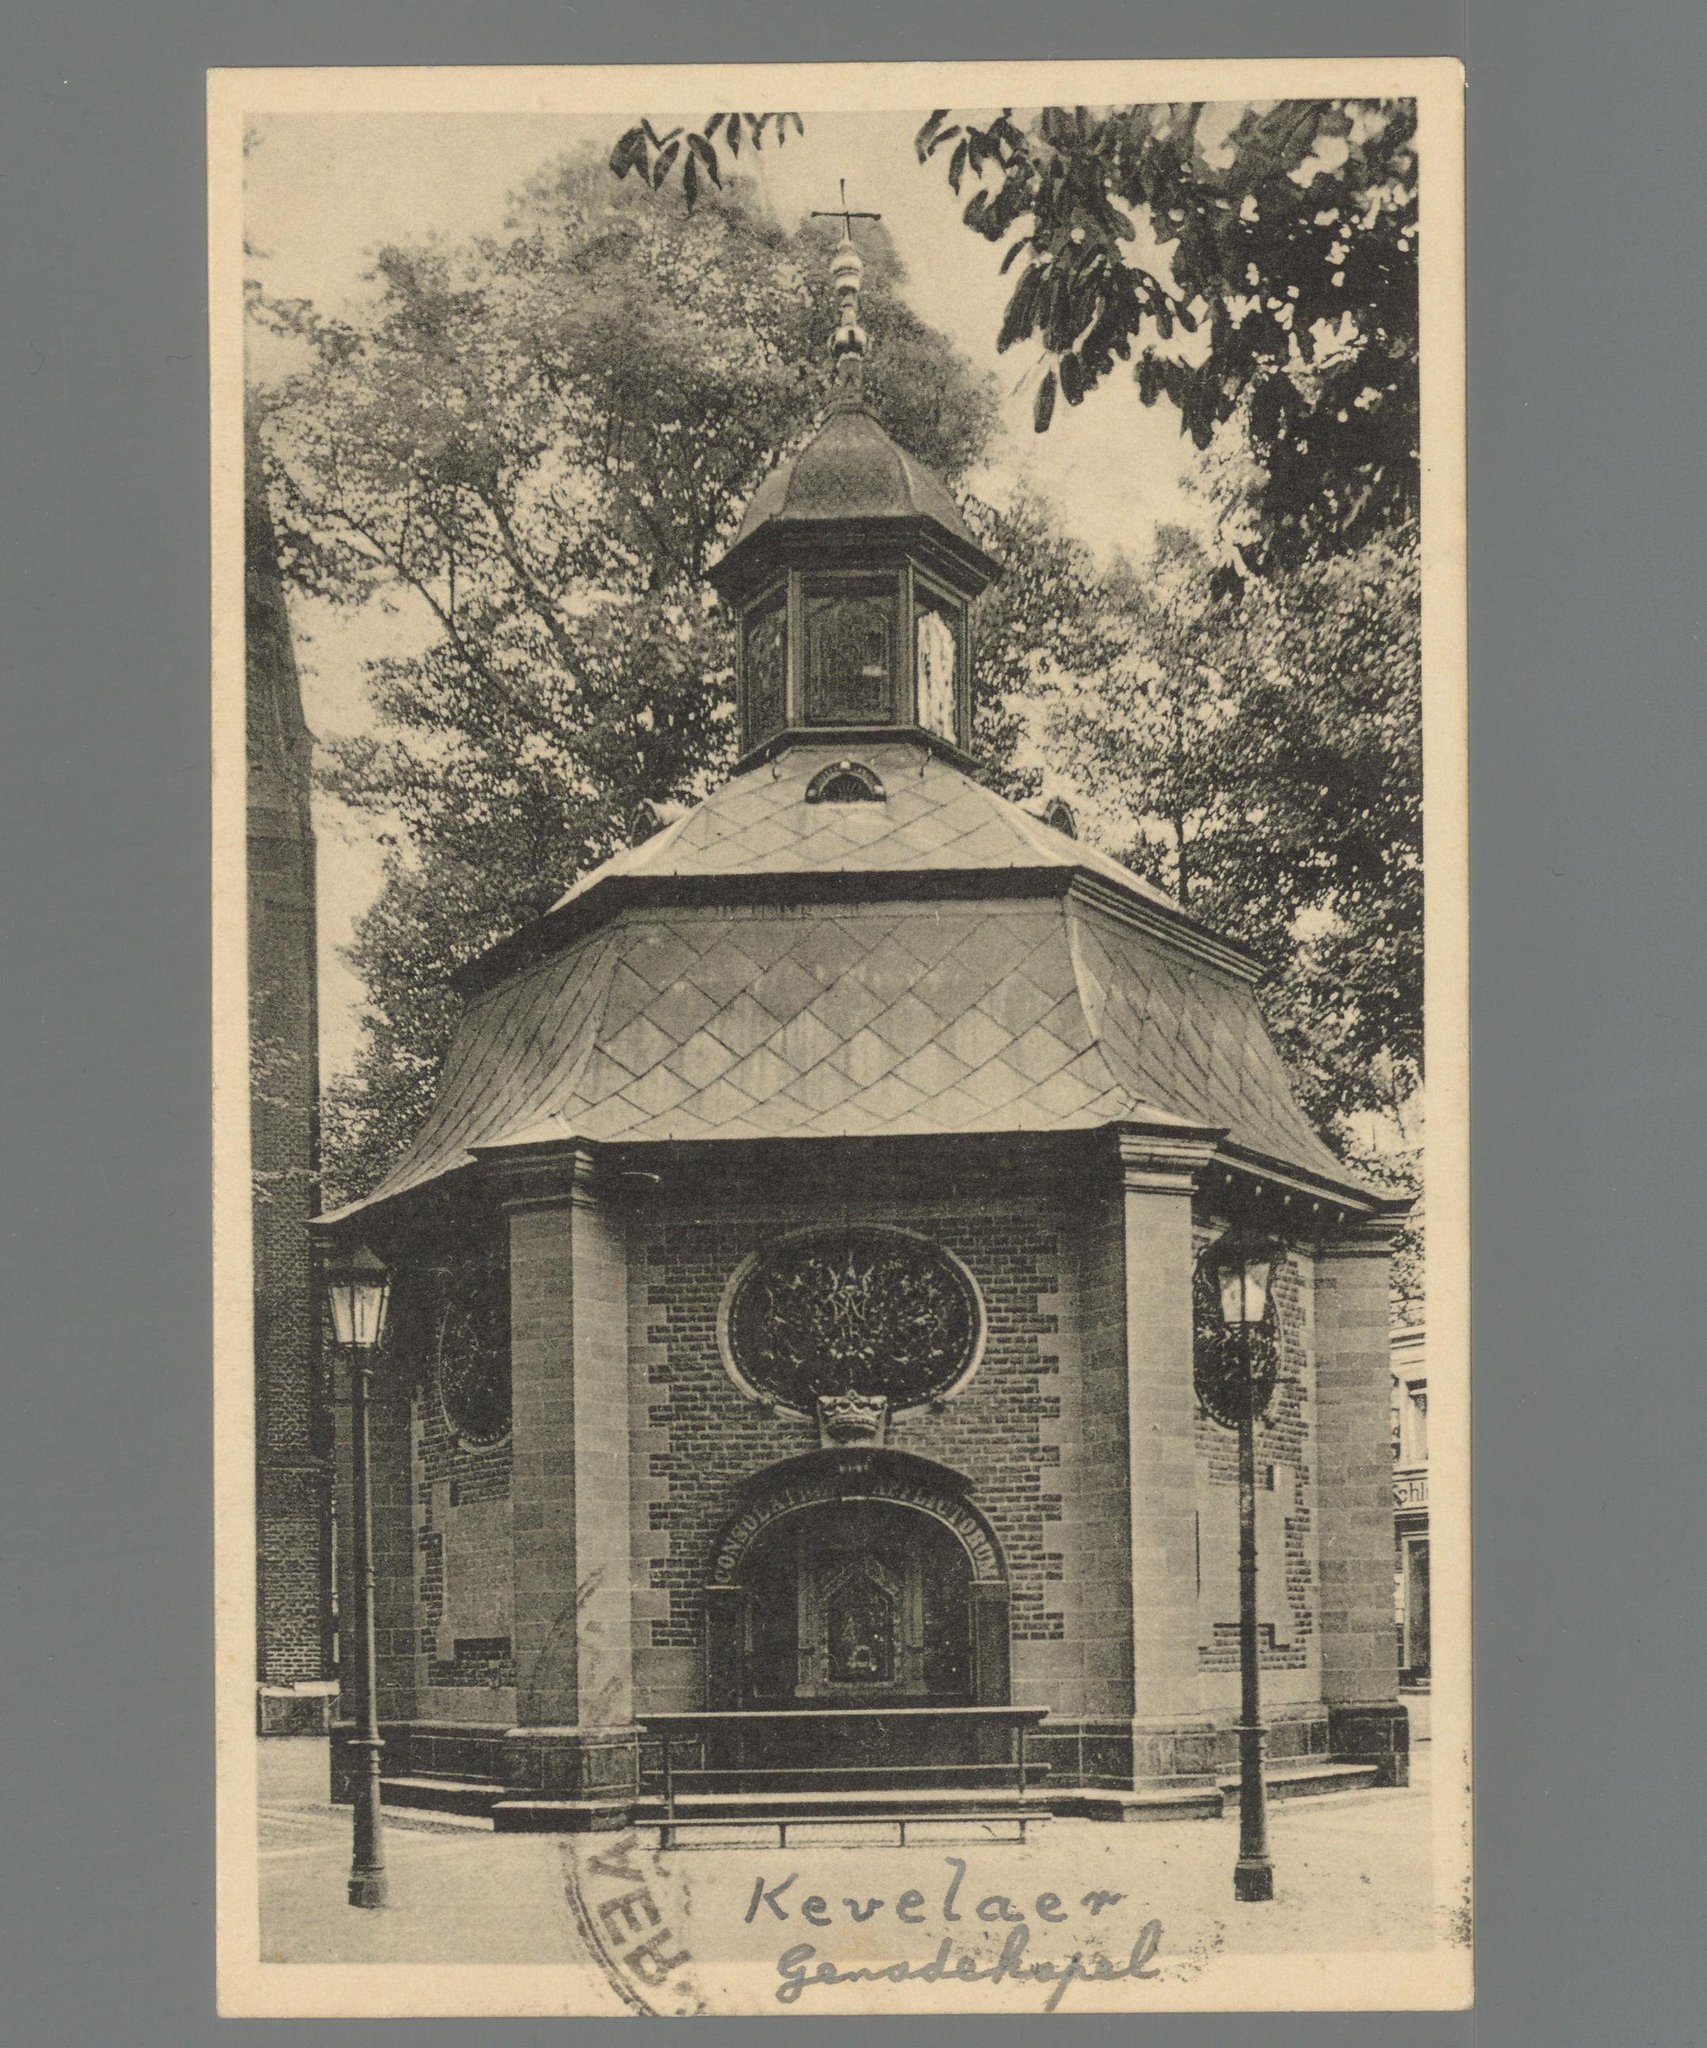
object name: ansichtkaart, prentbriefkaart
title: Kevelaer, Gnadenkapelle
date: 1905-1936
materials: cardboard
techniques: photograph, writing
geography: kevelaer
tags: parts of church exterior and annexes: chapel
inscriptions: poststempel, verso, gestempeld